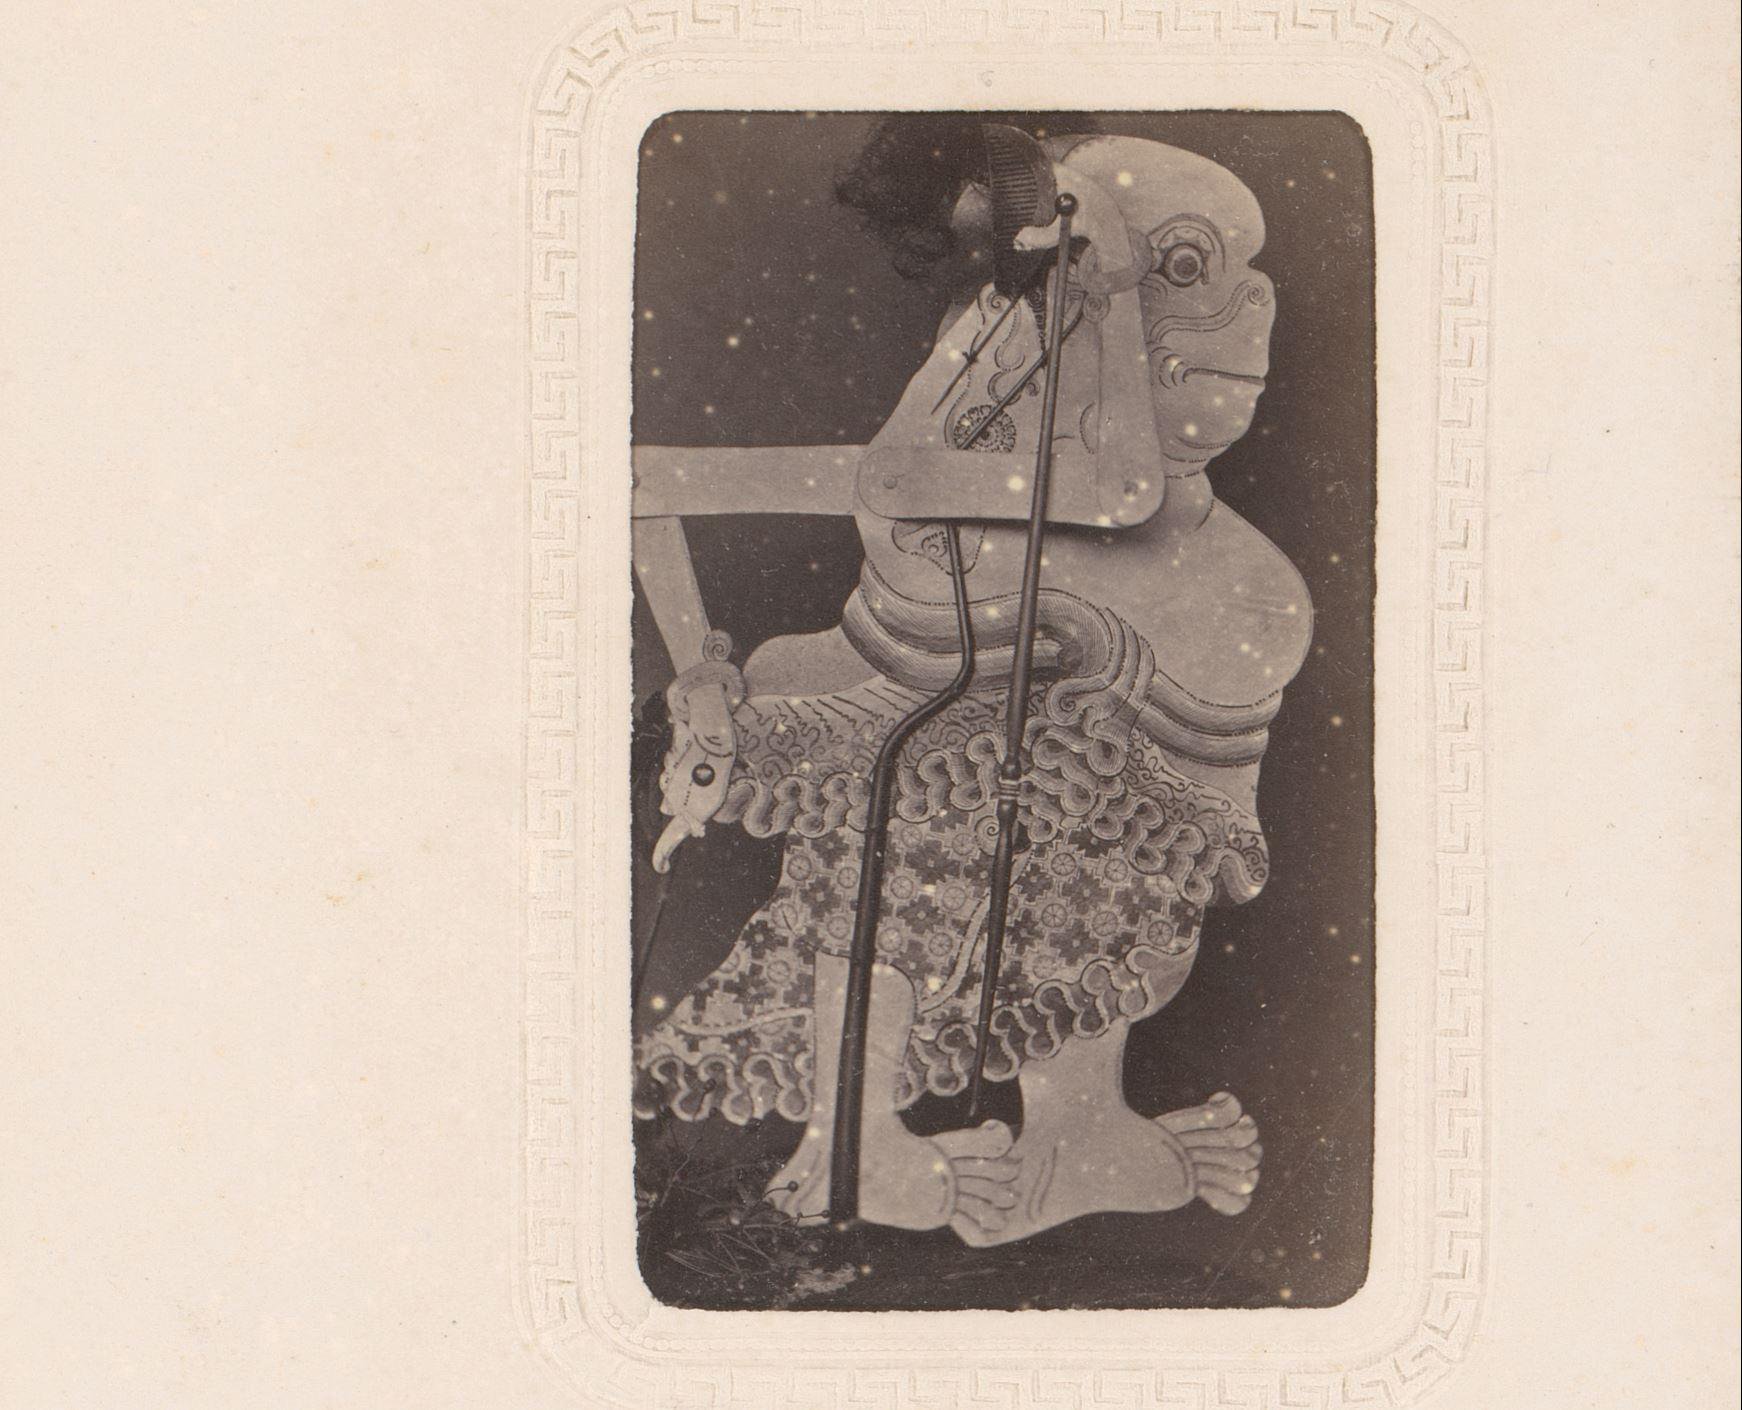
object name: album leaf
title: Wajangpop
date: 1857-1880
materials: cardboard, photographic support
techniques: albumen print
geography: java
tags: puppet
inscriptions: inscription: ‘Woodbury & Page/ Photographers/ Java’, number: ‘86’